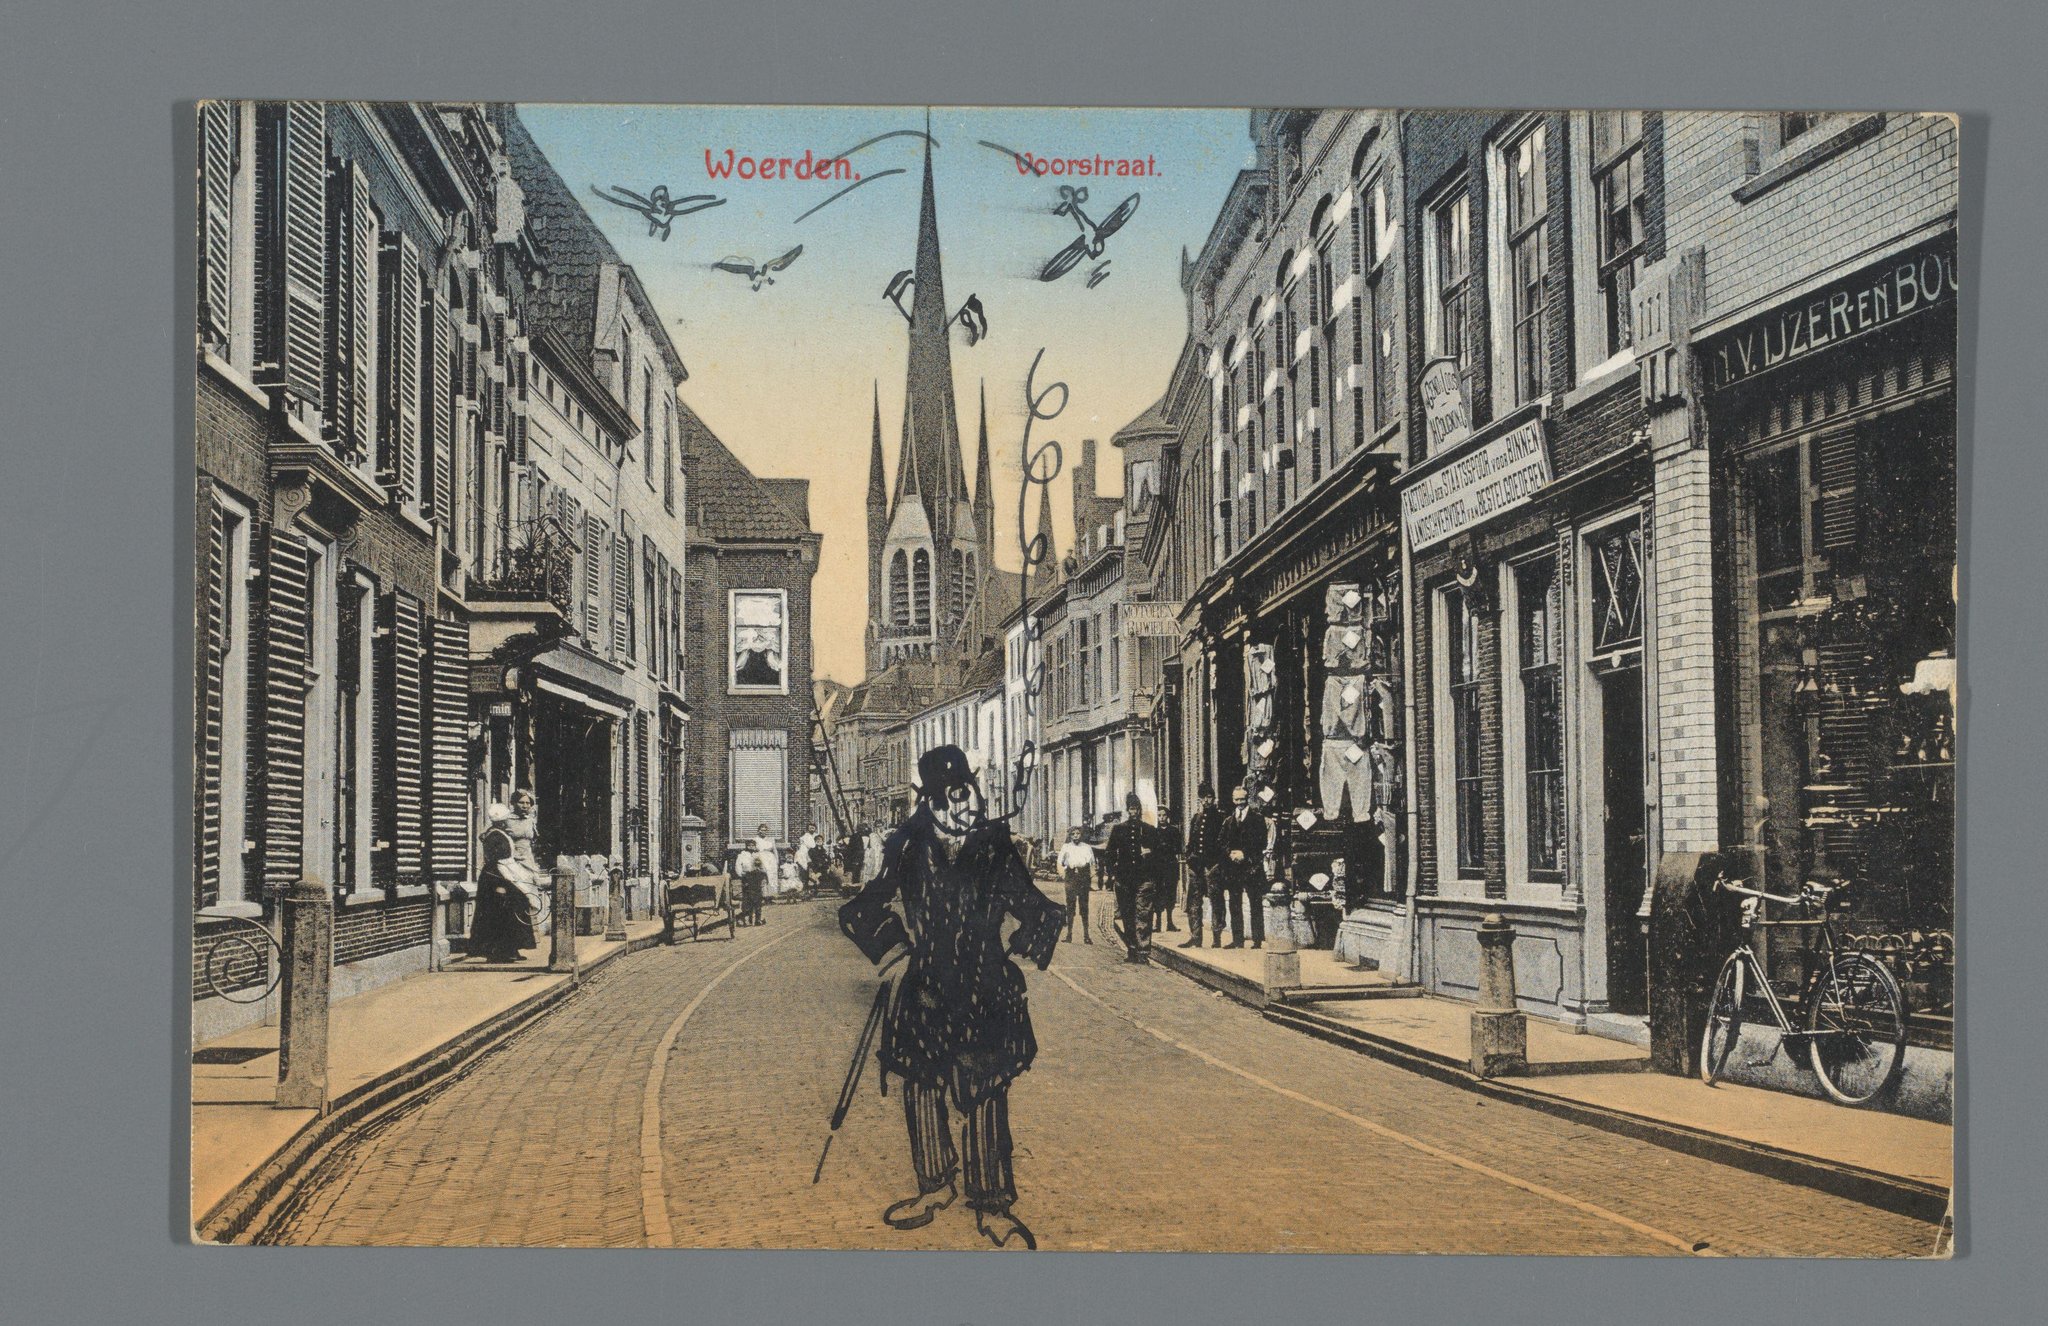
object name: ansichtkaart, prentbriefkaart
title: Prentbriefkaart aan Jan Ponstijn en Henriëtte Johanna Petronella van Hilten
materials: cardboard, ink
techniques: collotype process, pen, writing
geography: leiden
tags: henriëtte johanna petronella ponstijn-van hilten, amsterdam, print maker, draughtsman, jan petrus ponstijn, portrait, self-portrait of artist, street (+ city(-scape) with figures, staffage)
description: Prentbriefkaart met een tekening van Leo Gestel in de Voorstraat te Woerden. Prentbriefkaart maakt deel uit van een album.